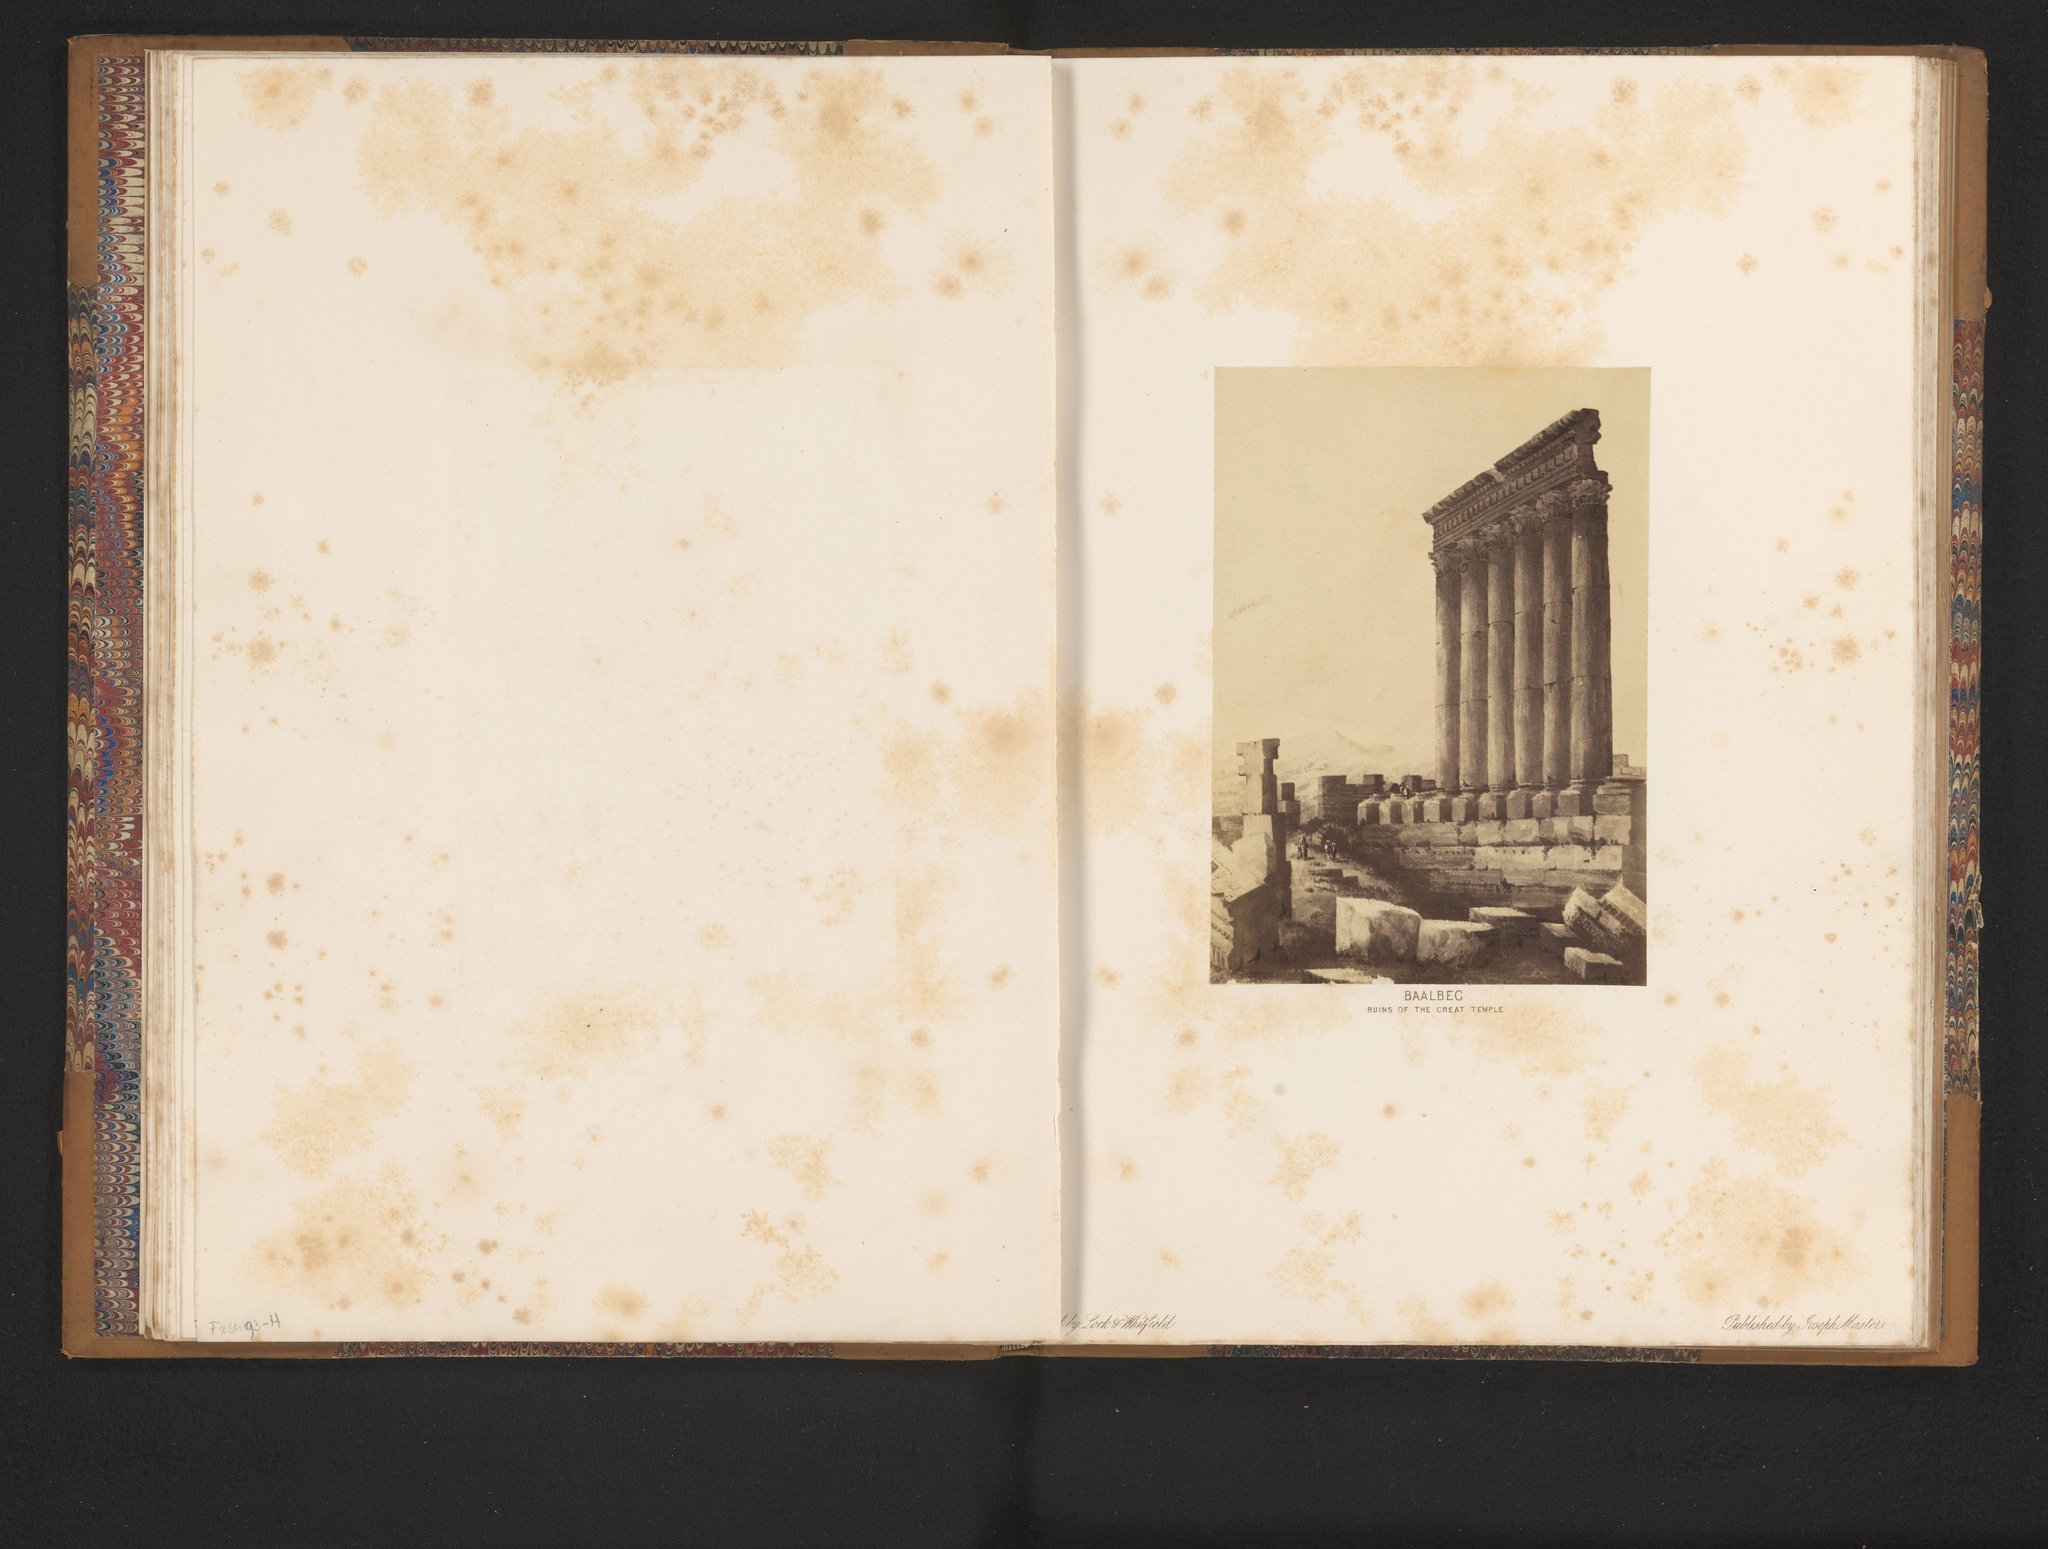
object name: photograph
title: Baalbec, ruins of the Great Temple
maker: conway mordaunt shipley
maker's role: draughtsman, painter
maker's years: 1824-1888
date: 1855-1865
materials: paper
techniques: albumen print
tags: landscape with ruins